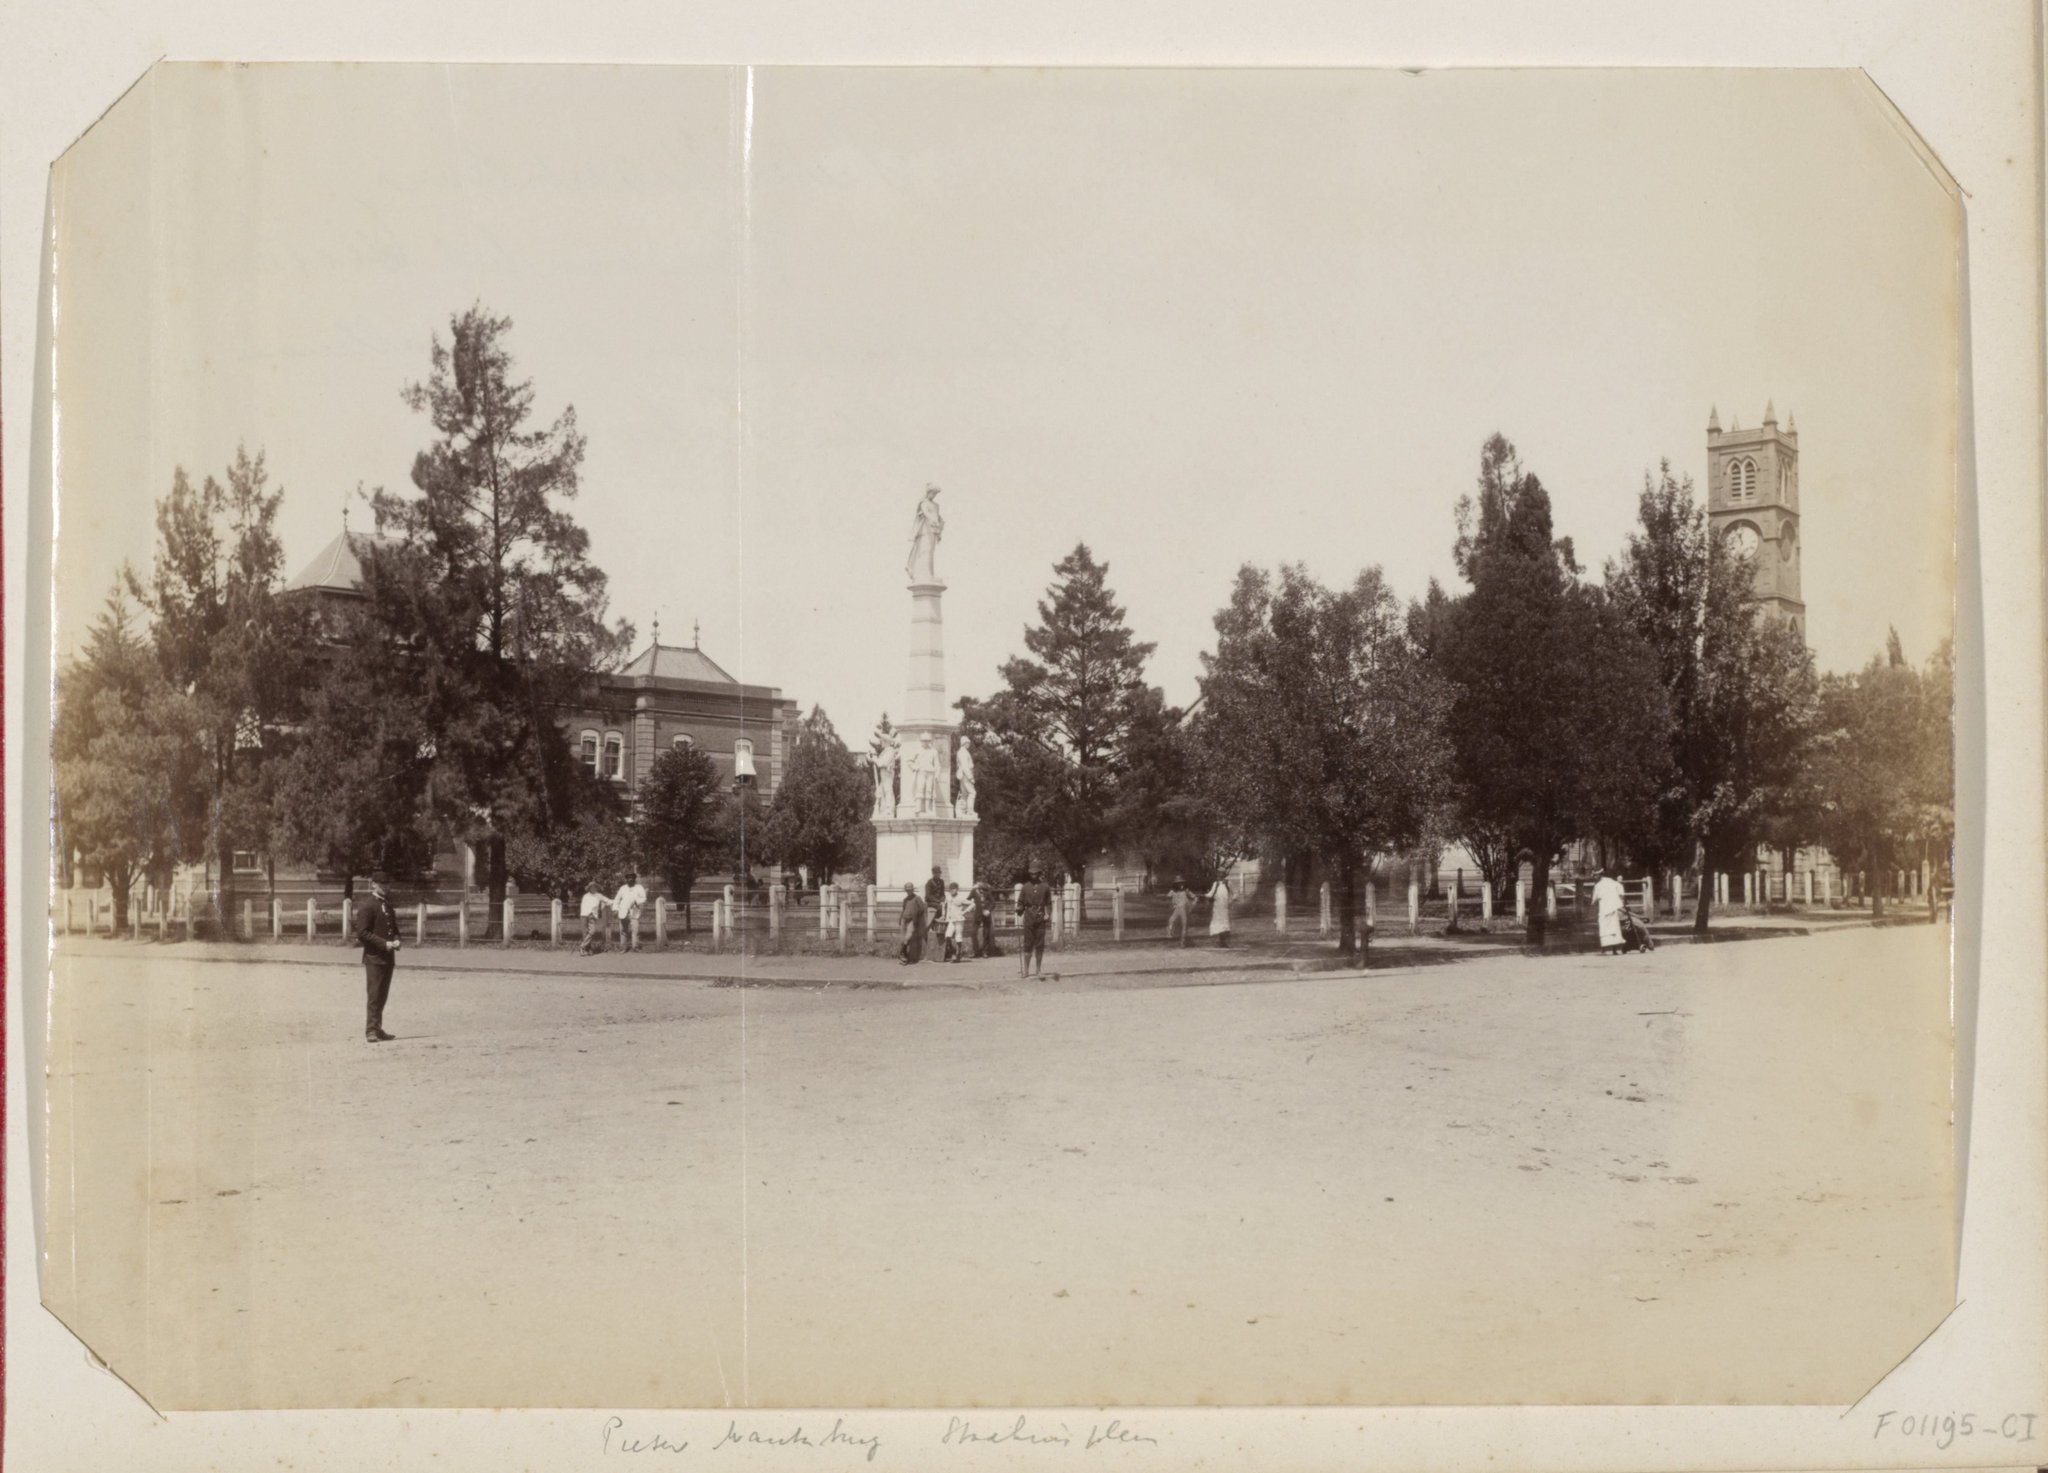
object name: photograph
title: Plein in Pietermaritzburg met centraal het monument ter nagedachtenis van de gevallenen in de Zoeloe-oorlog van 1879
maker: Anonymous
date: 1879-1910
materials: cardboard, paper, photographic support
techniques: albumen print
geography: pietermaritzburg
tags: monument, statue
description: Onderdeel van Fotoalbum van een reis door de Verenigde Staten, Honolulu, Nederlands-Indië, Aden, Zanzibar en Zuidelijk Afrika.